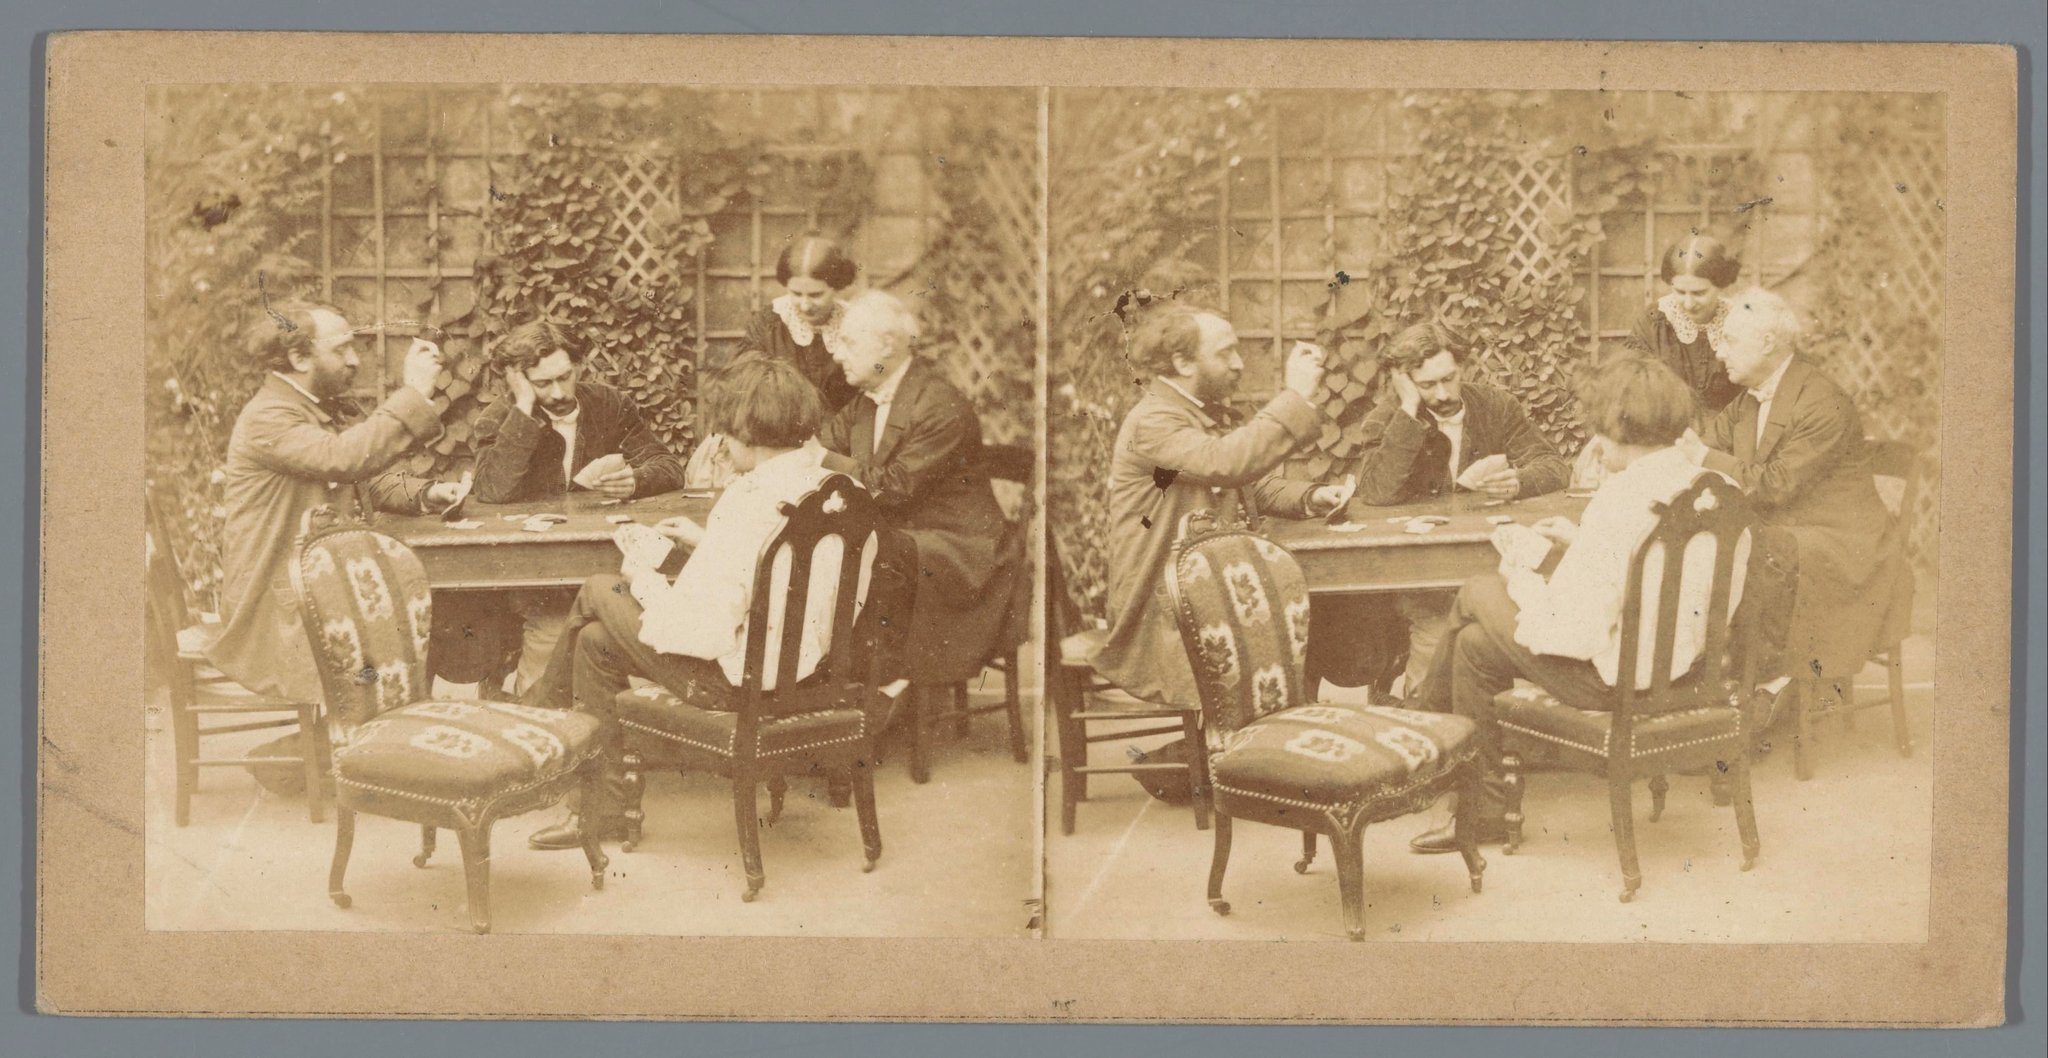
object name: stereograph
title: Kaartend gezelschap aan een buitentafel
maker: Anonymous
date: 1850-1880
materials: cardboard, photographic support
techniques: albumen print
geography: paris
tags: playing-cards, europe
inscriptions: number: ‘3209 70’, name: ‘Feldbrugge & Co. Groningen’